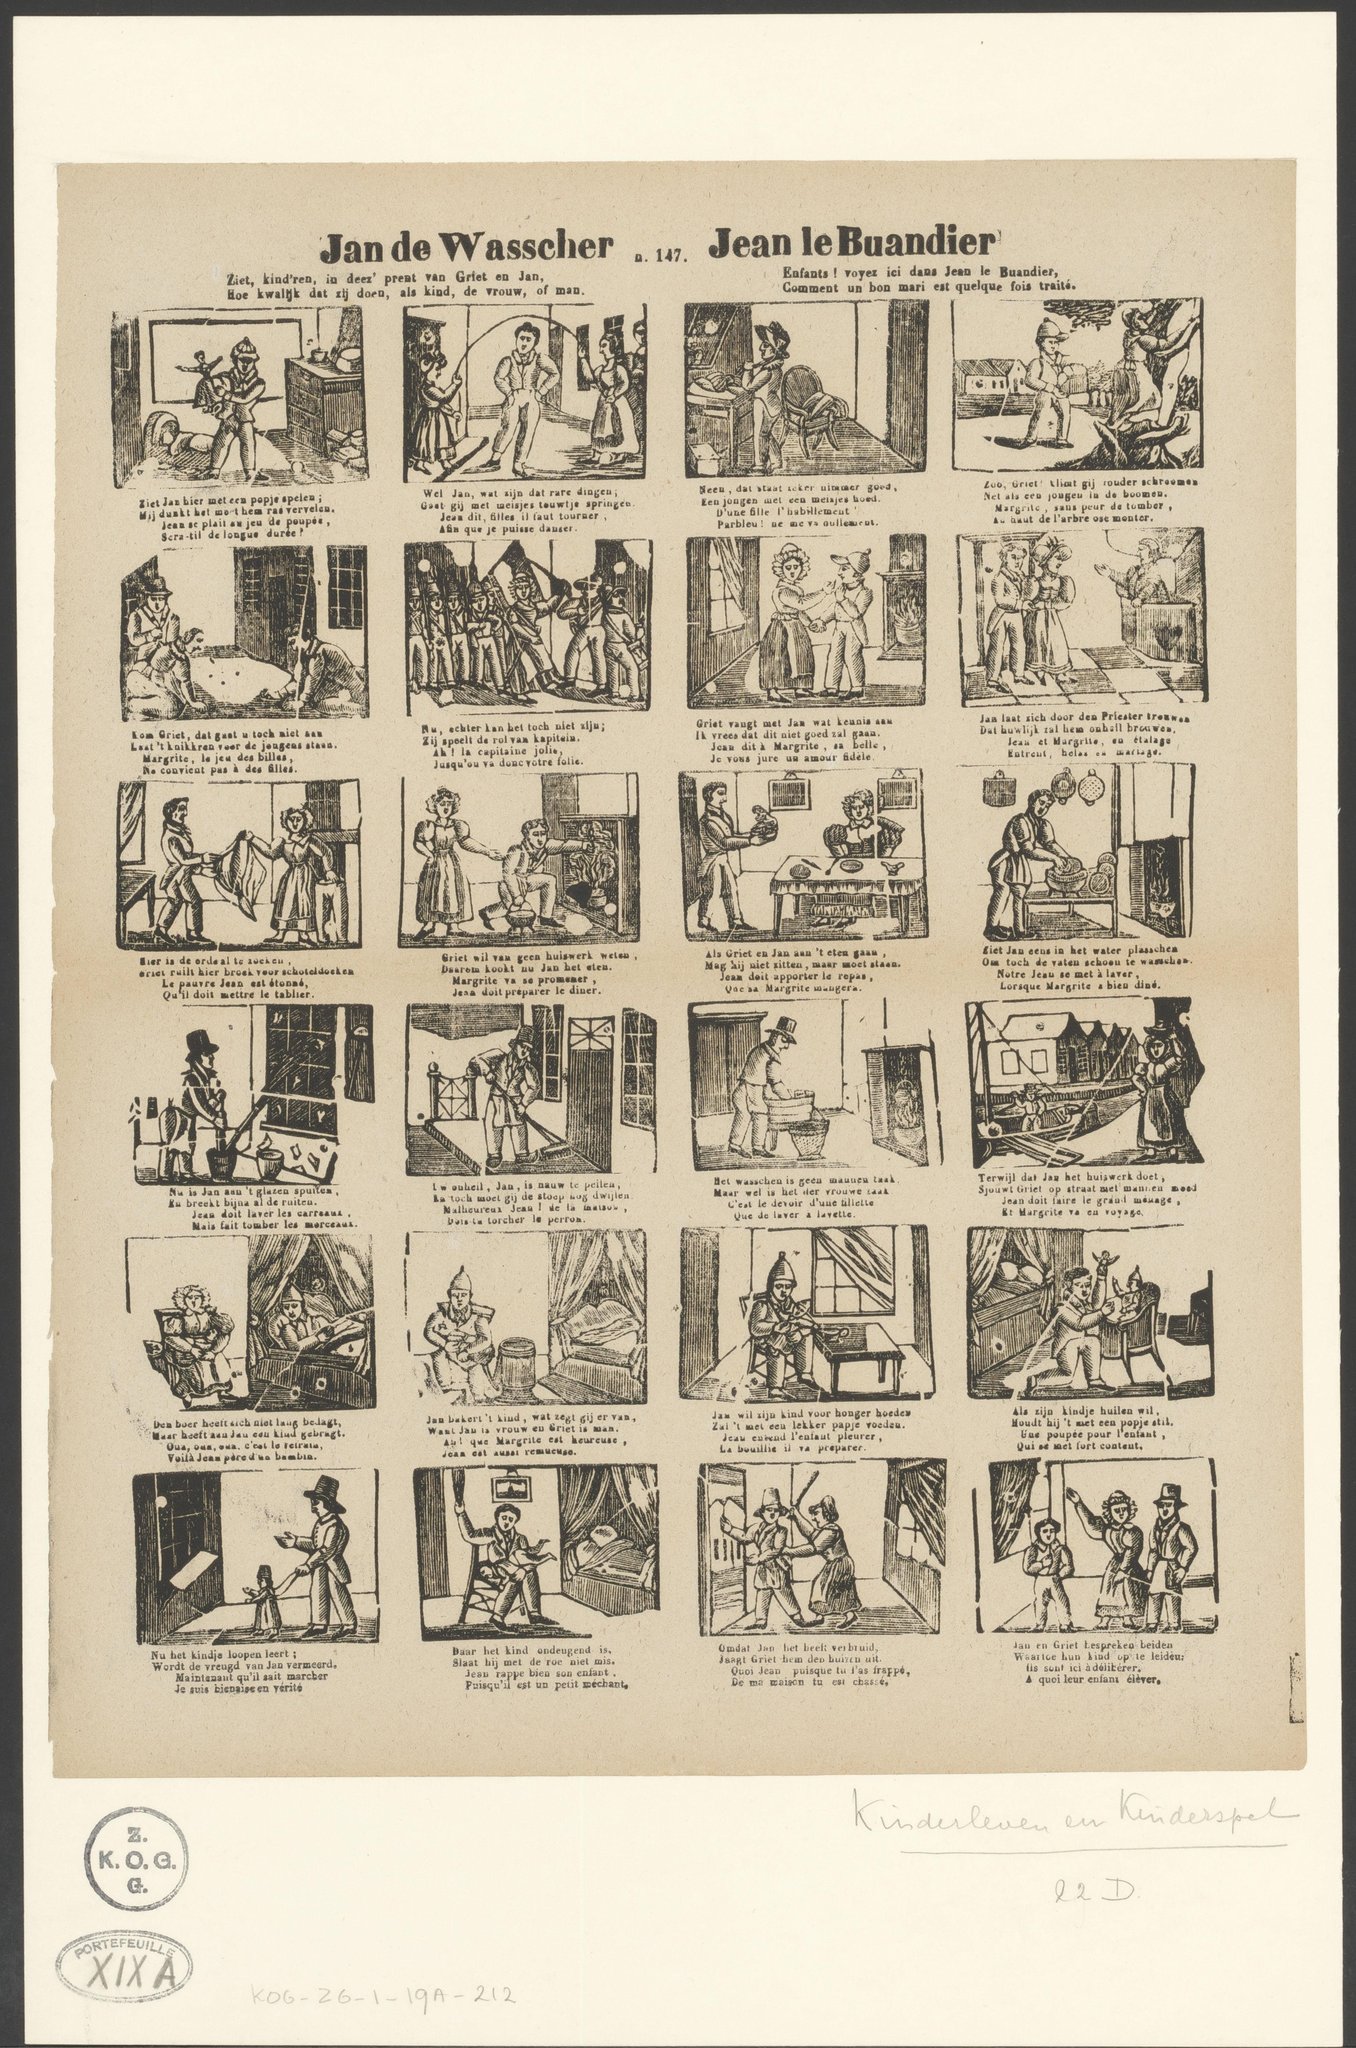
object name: popular print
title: Leven van Jan de Wasser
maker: Anonymous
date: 1797-1813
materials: paper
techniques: letterpress printing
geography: turnhout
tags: hen-pecked husband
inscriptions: collector's mark: Lugt 1641, stamp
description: Vierentwintig voorstellingen uit het leven van Jan de Wasscher. Onder elke afbeelding een tweeregelig vers in het Nederlands en Frans. Genummerd bovenaan: No. n. 147. Onderwerpsrubrieken binnen de Atlas Zeden en Gewoonten: Zeden en Gewoonten in Engeren Zin, Des menschen beging, midden en einde, Kinderleven – Kinderspel en Kinderprenten.